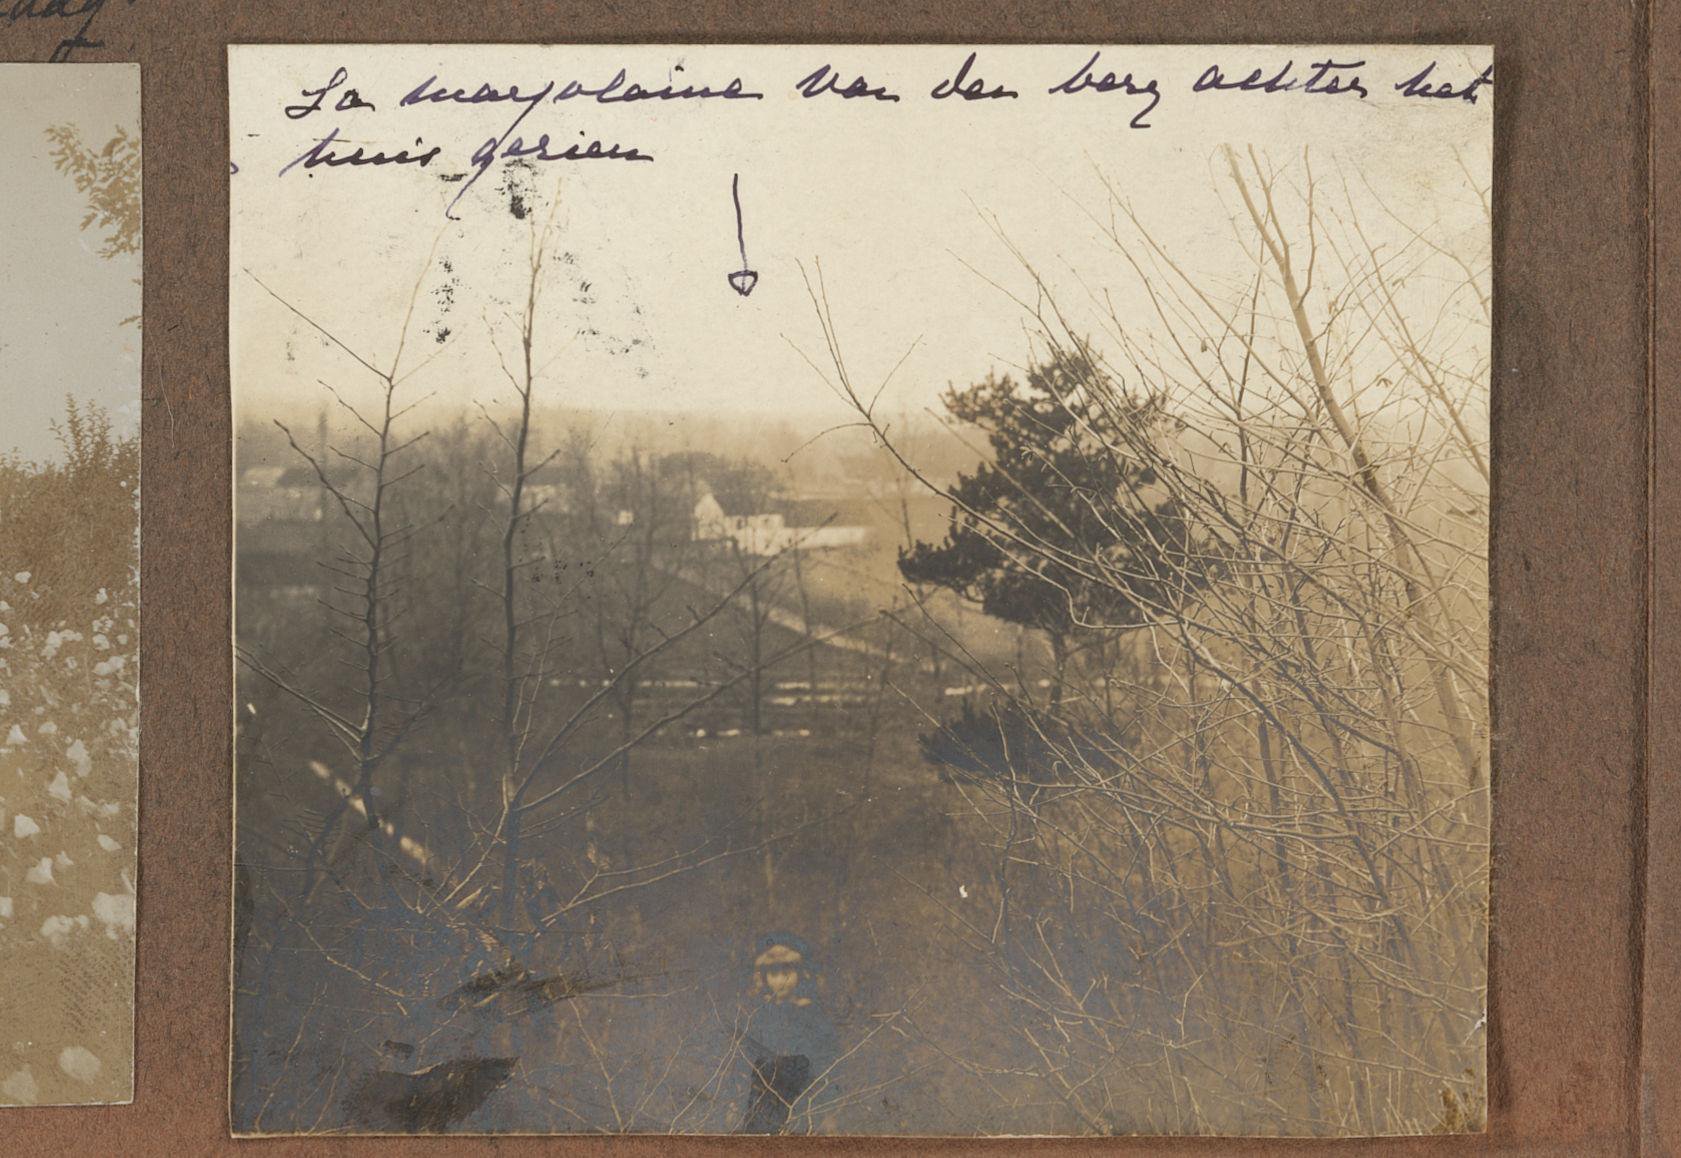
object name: photograph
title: La mayolaine van den berg achter het huis gezien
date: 1890-1920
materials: photographic support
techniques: photography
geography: netherlands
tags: netherlands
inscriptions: inscription: ‘La mayolaine van den berg achter het / huis gezien’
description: Foto op bruin albumblad 28 van familiealbum van Alphons Diepenbrock.